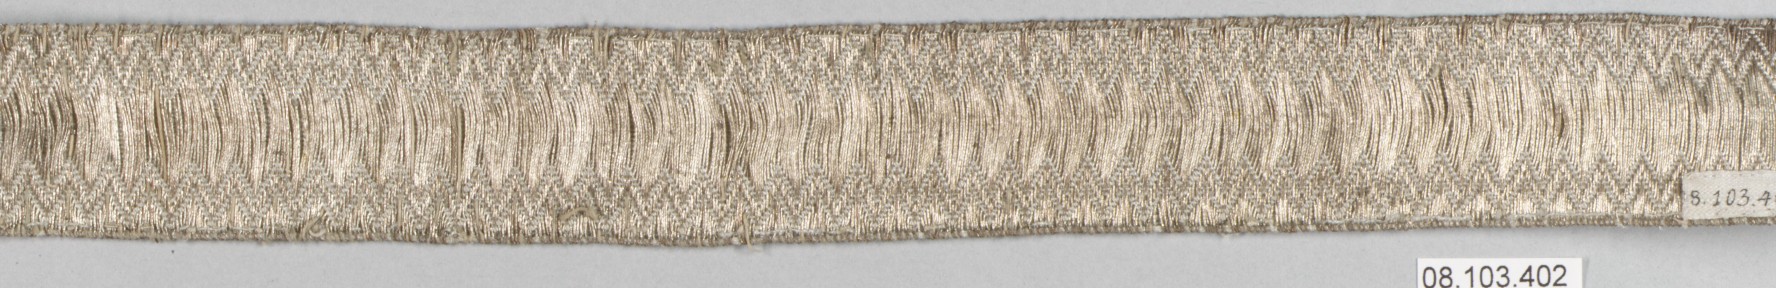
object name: galloon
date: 1701-1900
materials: metal thread